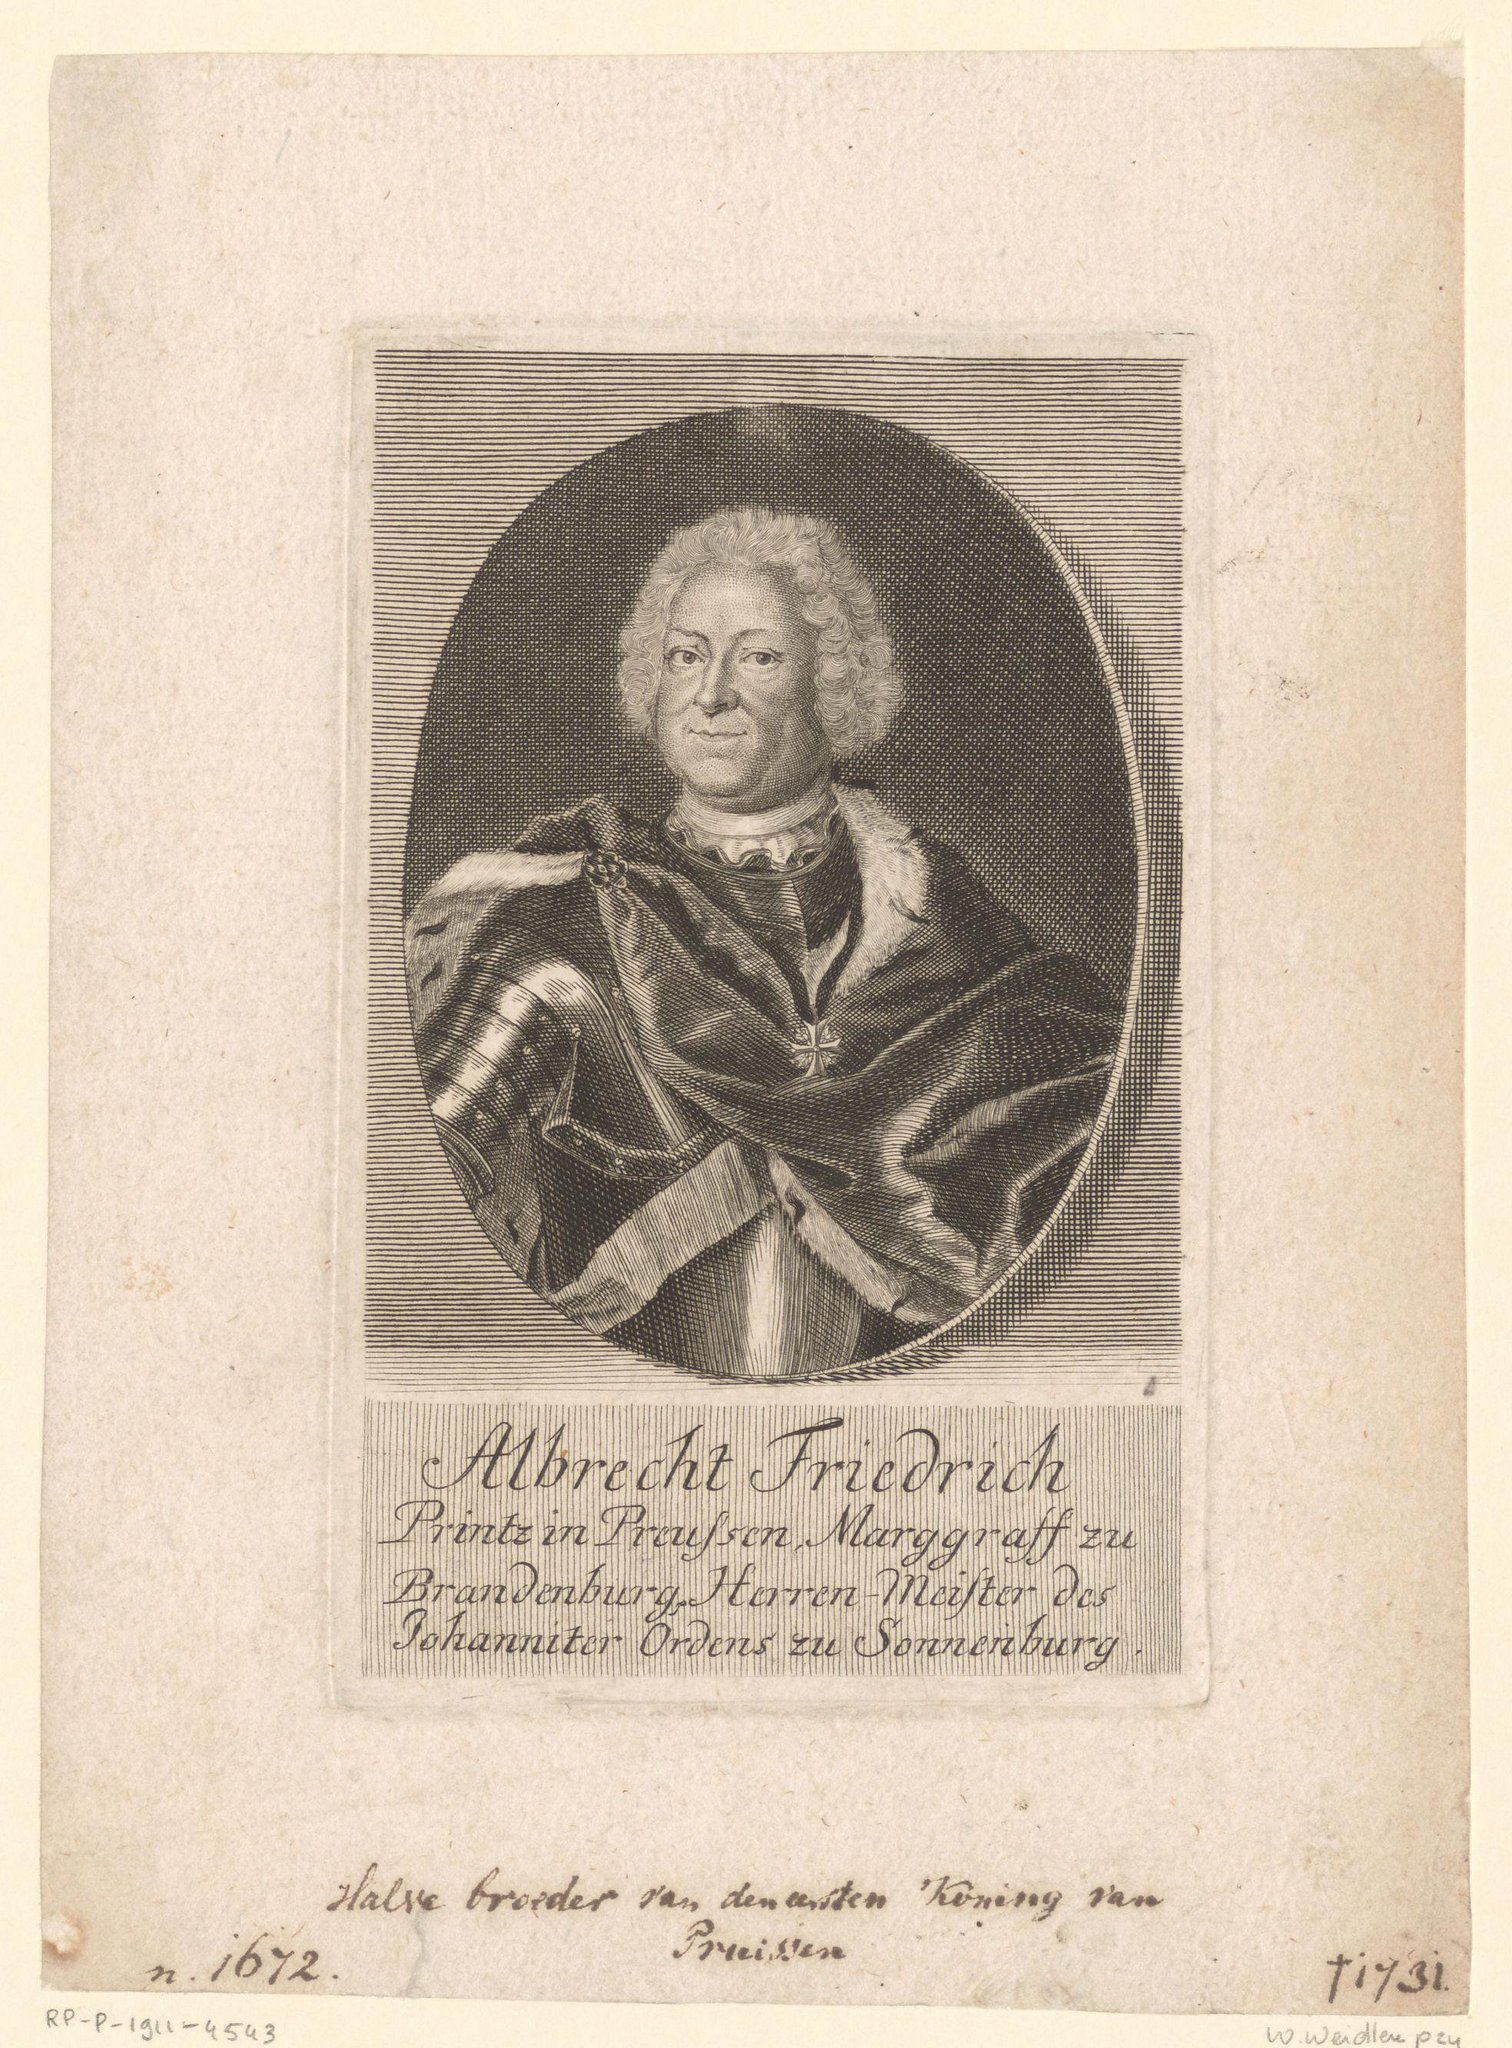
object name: print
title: Portret van Albrecht Friedrich von Brandenburg-Schwedt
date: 1700-1767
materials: paper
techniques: engraving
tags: armour, historical persons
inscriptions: collector's mark: Lugt 2228